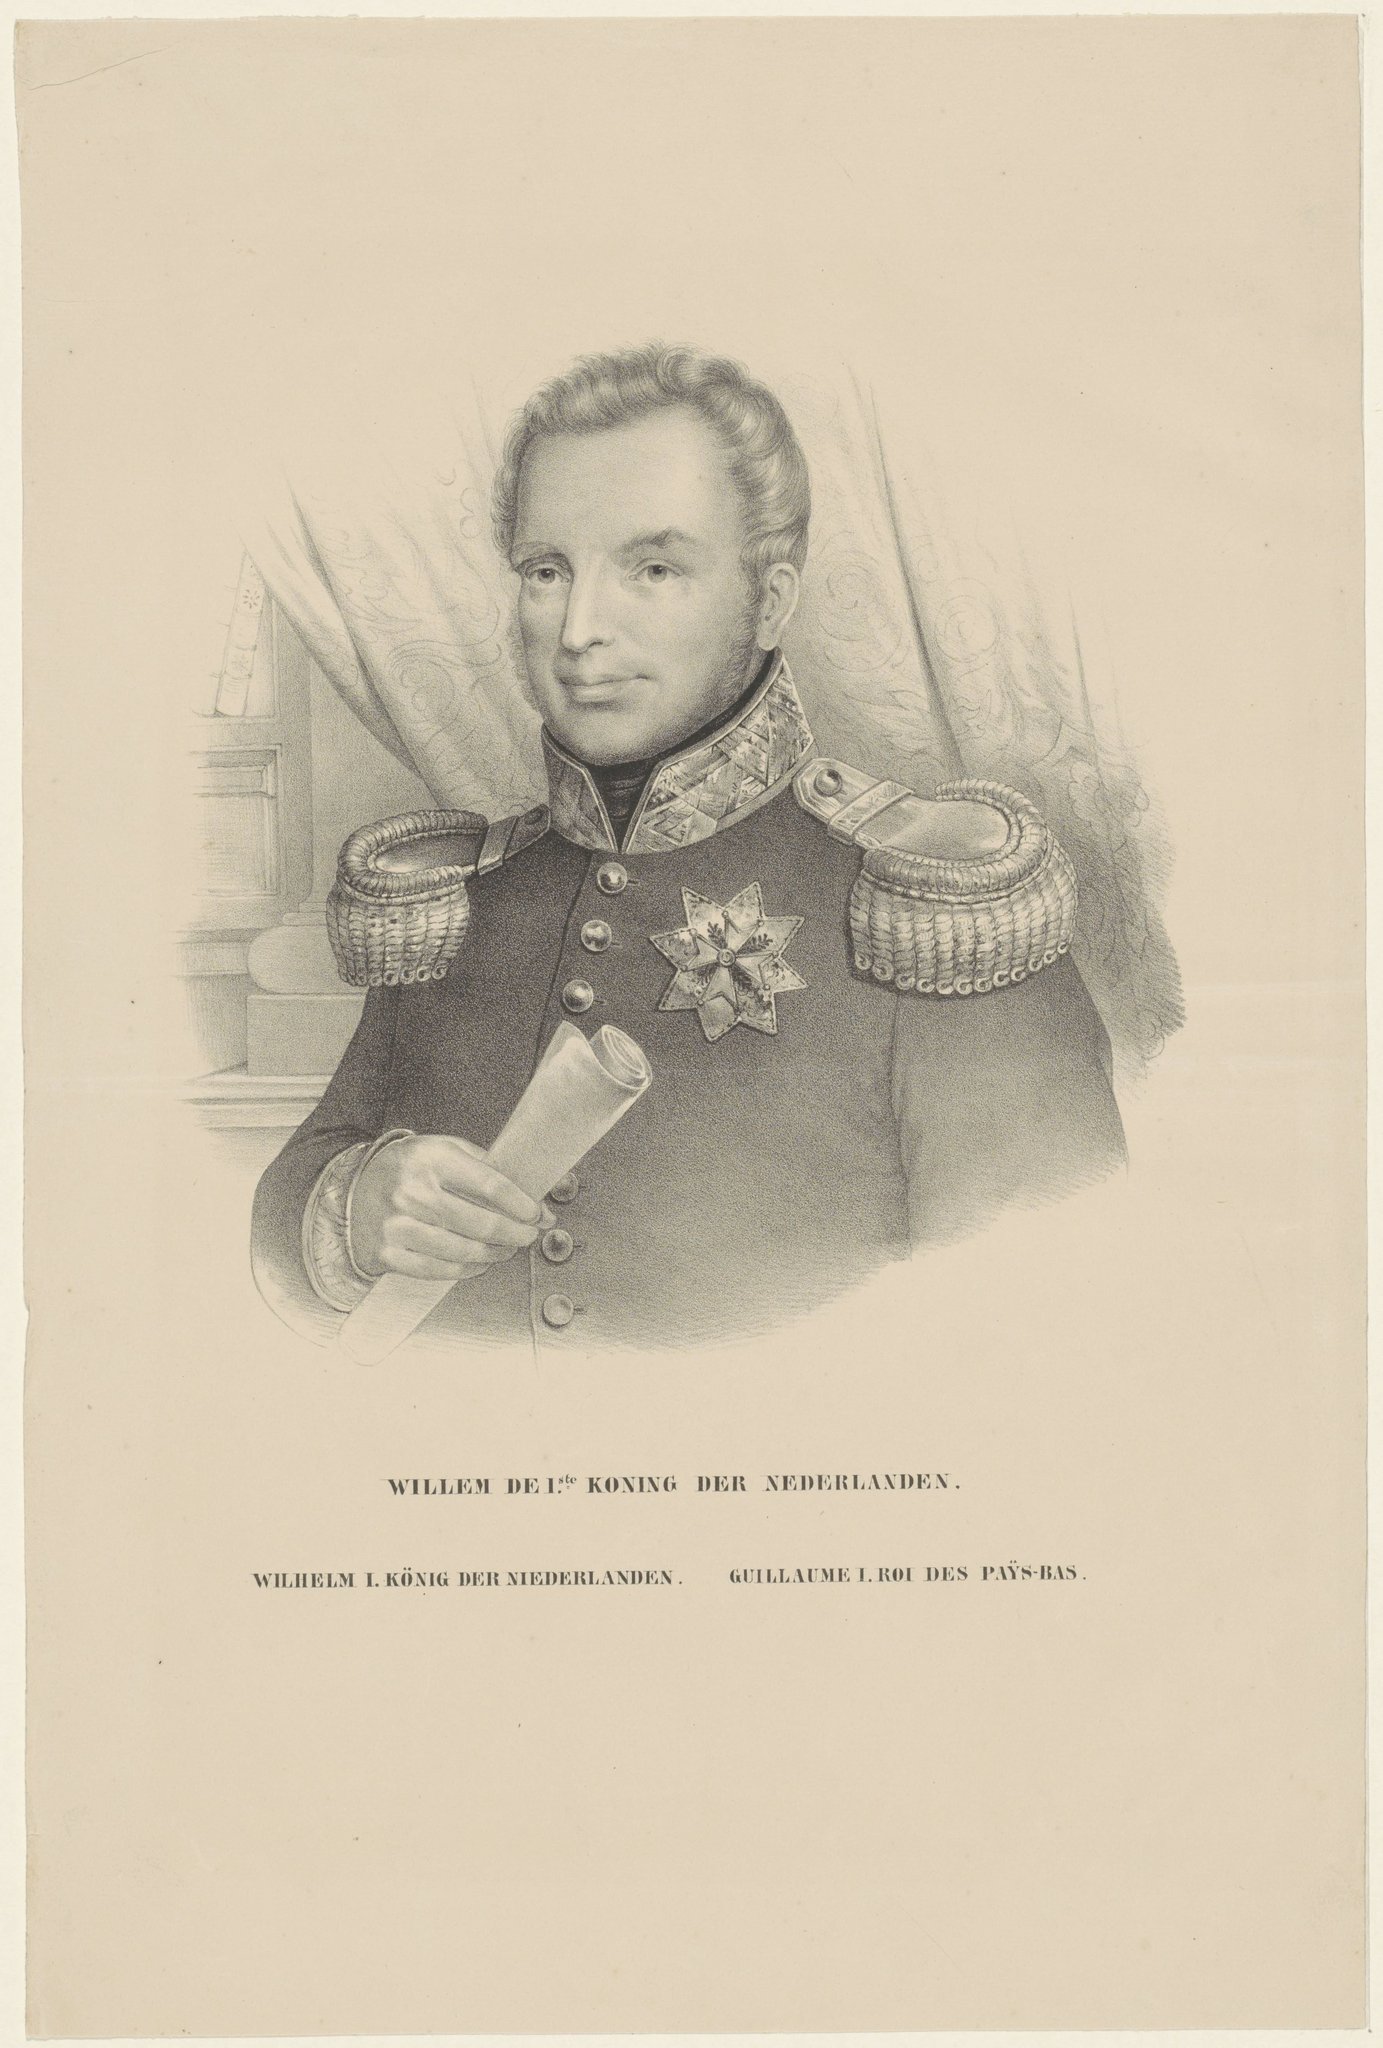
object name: print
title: Portret van Willem I Frederik, koning der Nederlanden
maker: Anonymous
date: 1815-1899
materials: paper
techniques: lithograph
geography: netherlands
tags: berlin, william i of the netherlands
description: De hier vermelde titel verwijst naar de hoogst verkregen titel van de geportretteerde, niet per se naar de titel die de geportretteerde op deze voorstelling draagt.